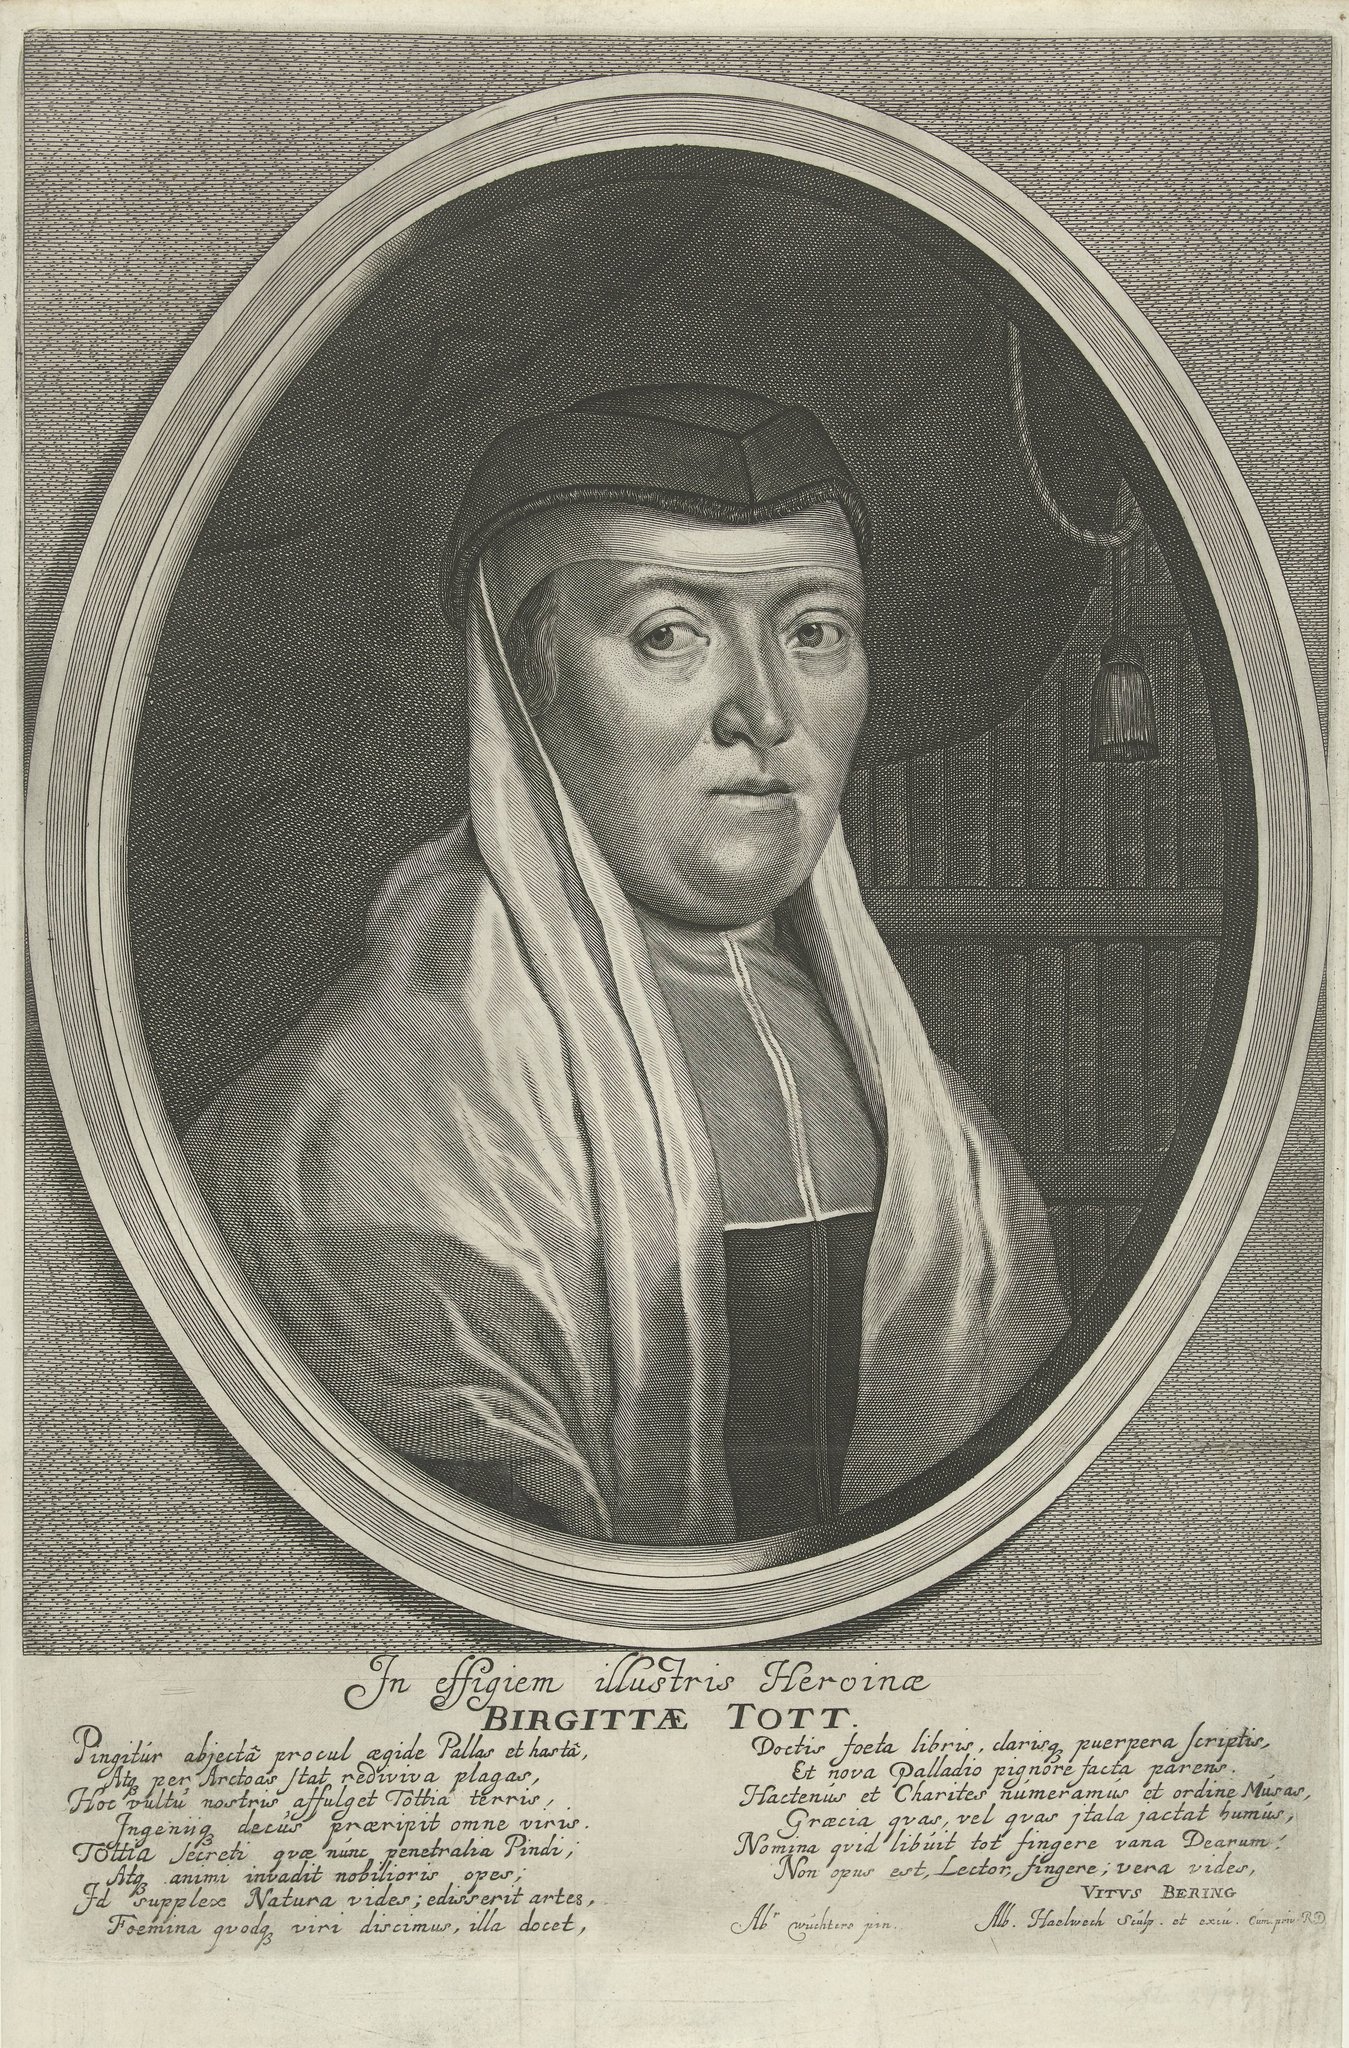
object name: print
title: Portret van Brigitta Tott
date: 1658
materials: paper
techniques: engraving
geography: copenhagen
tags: veil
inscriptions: collector's mark: Lugt 2228, collector's mark: Lugt 2760